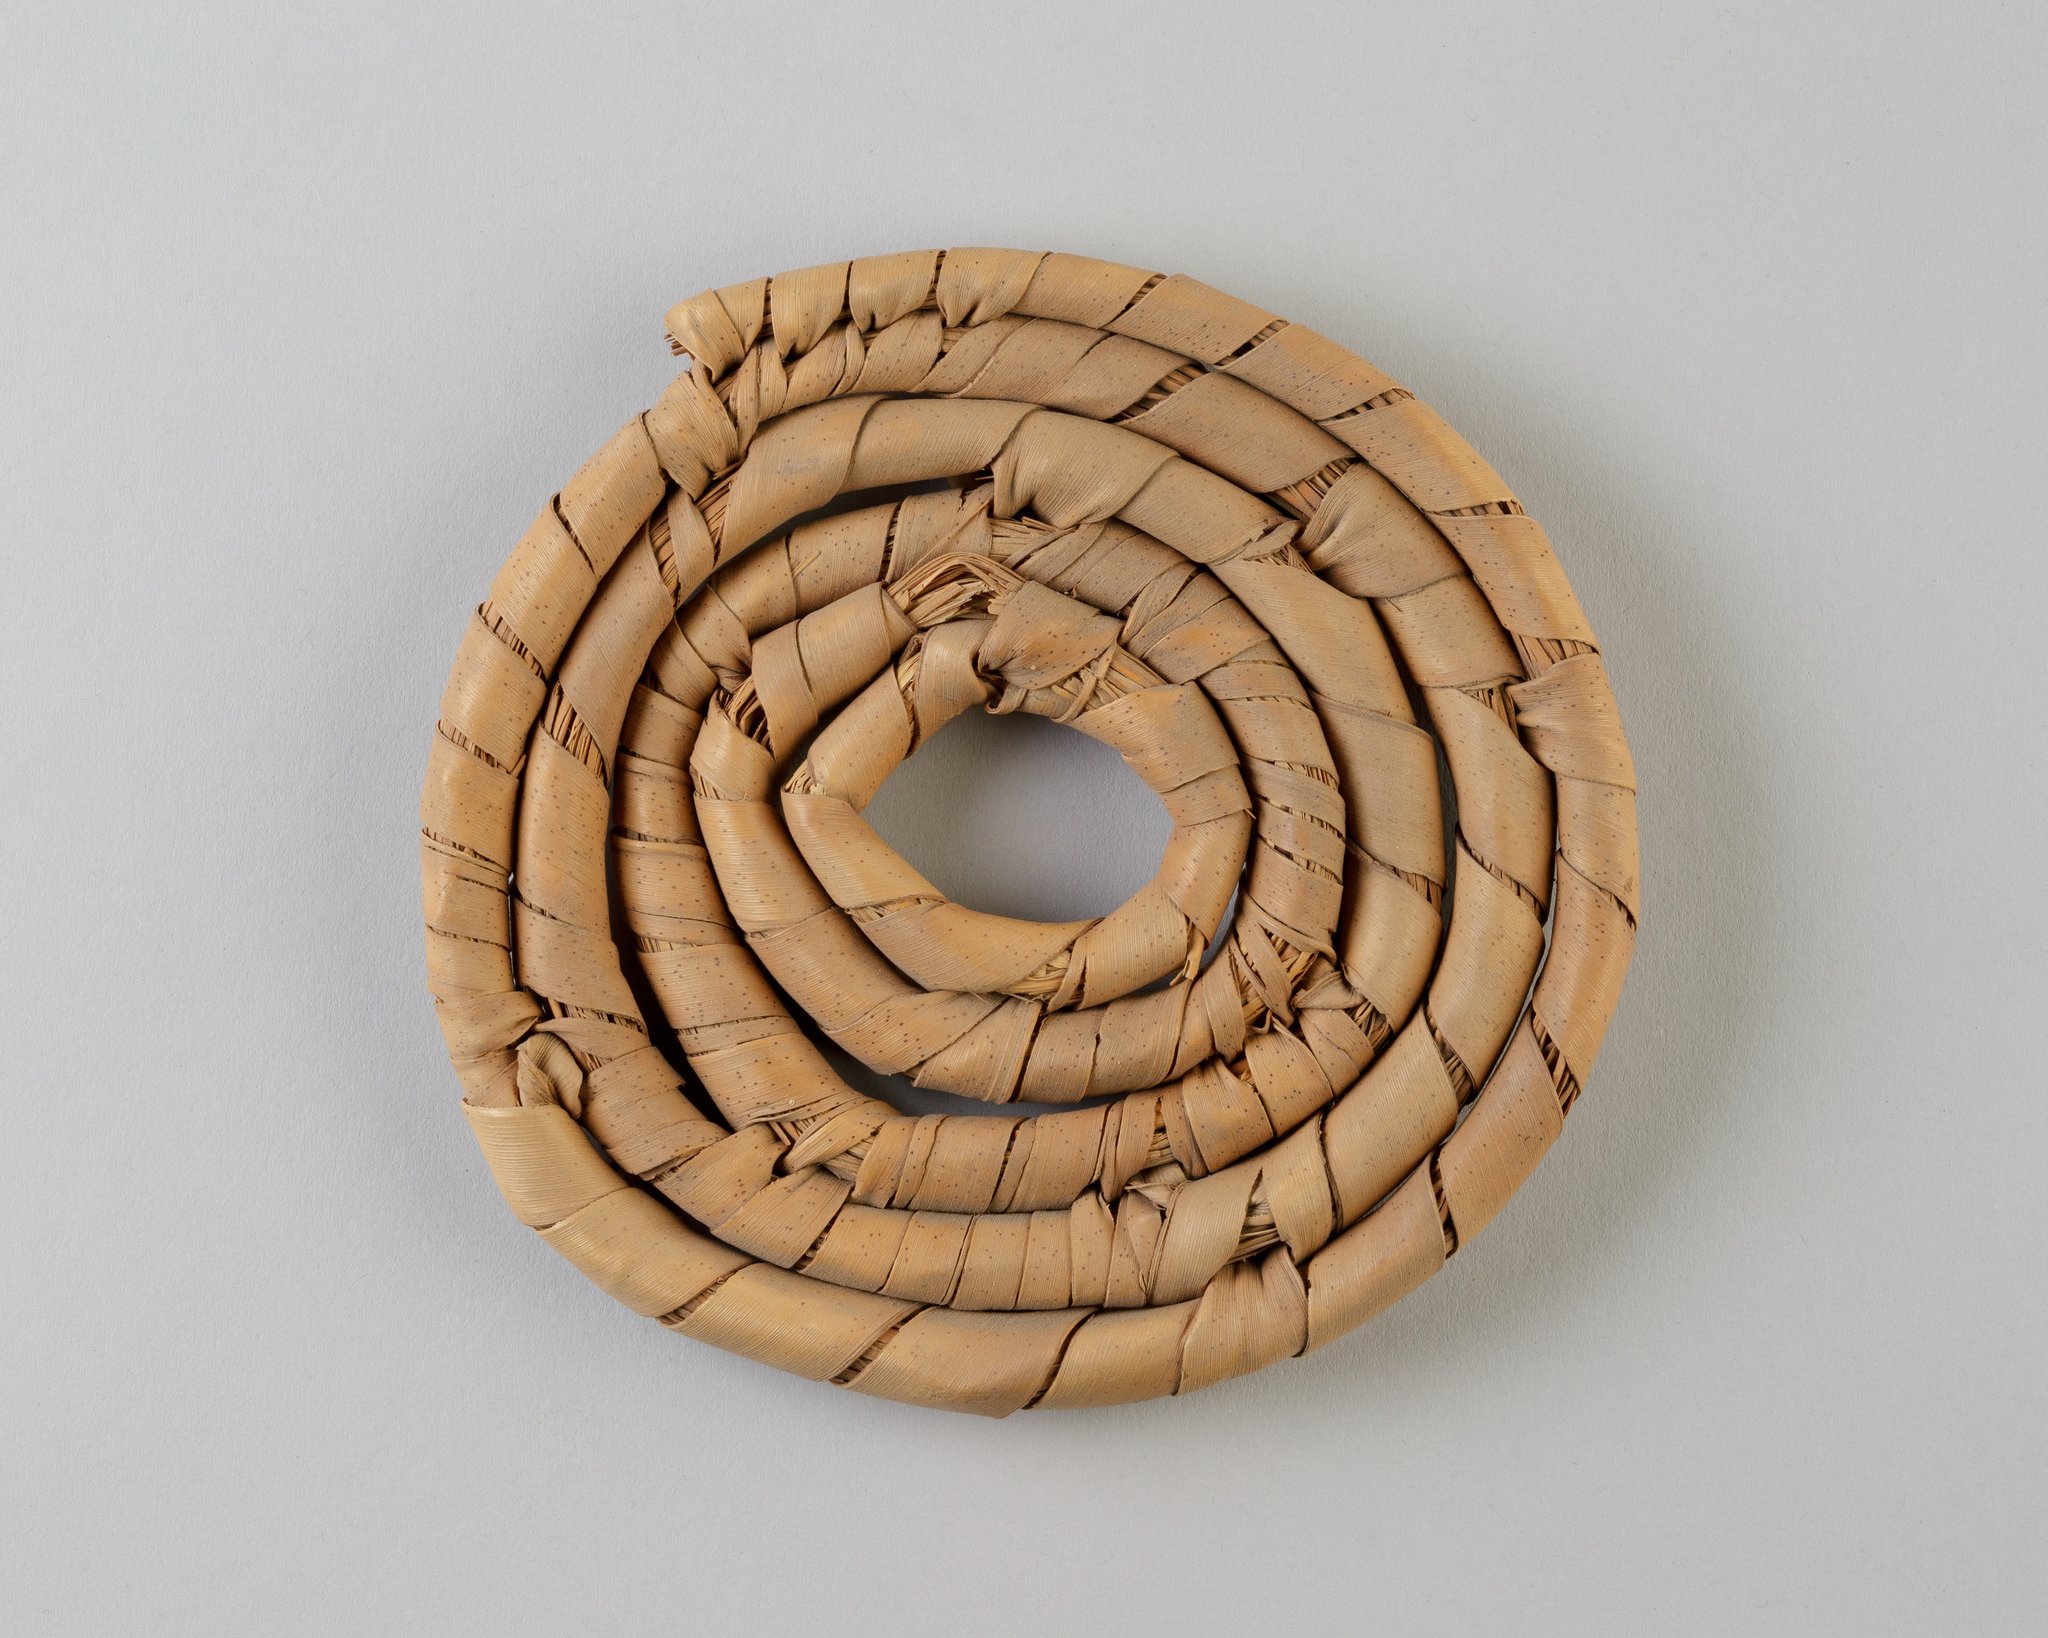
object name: basketry, model, senenmut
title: Pot Stand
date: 1479-1458 BCE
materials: leaf, fiber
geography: egypt